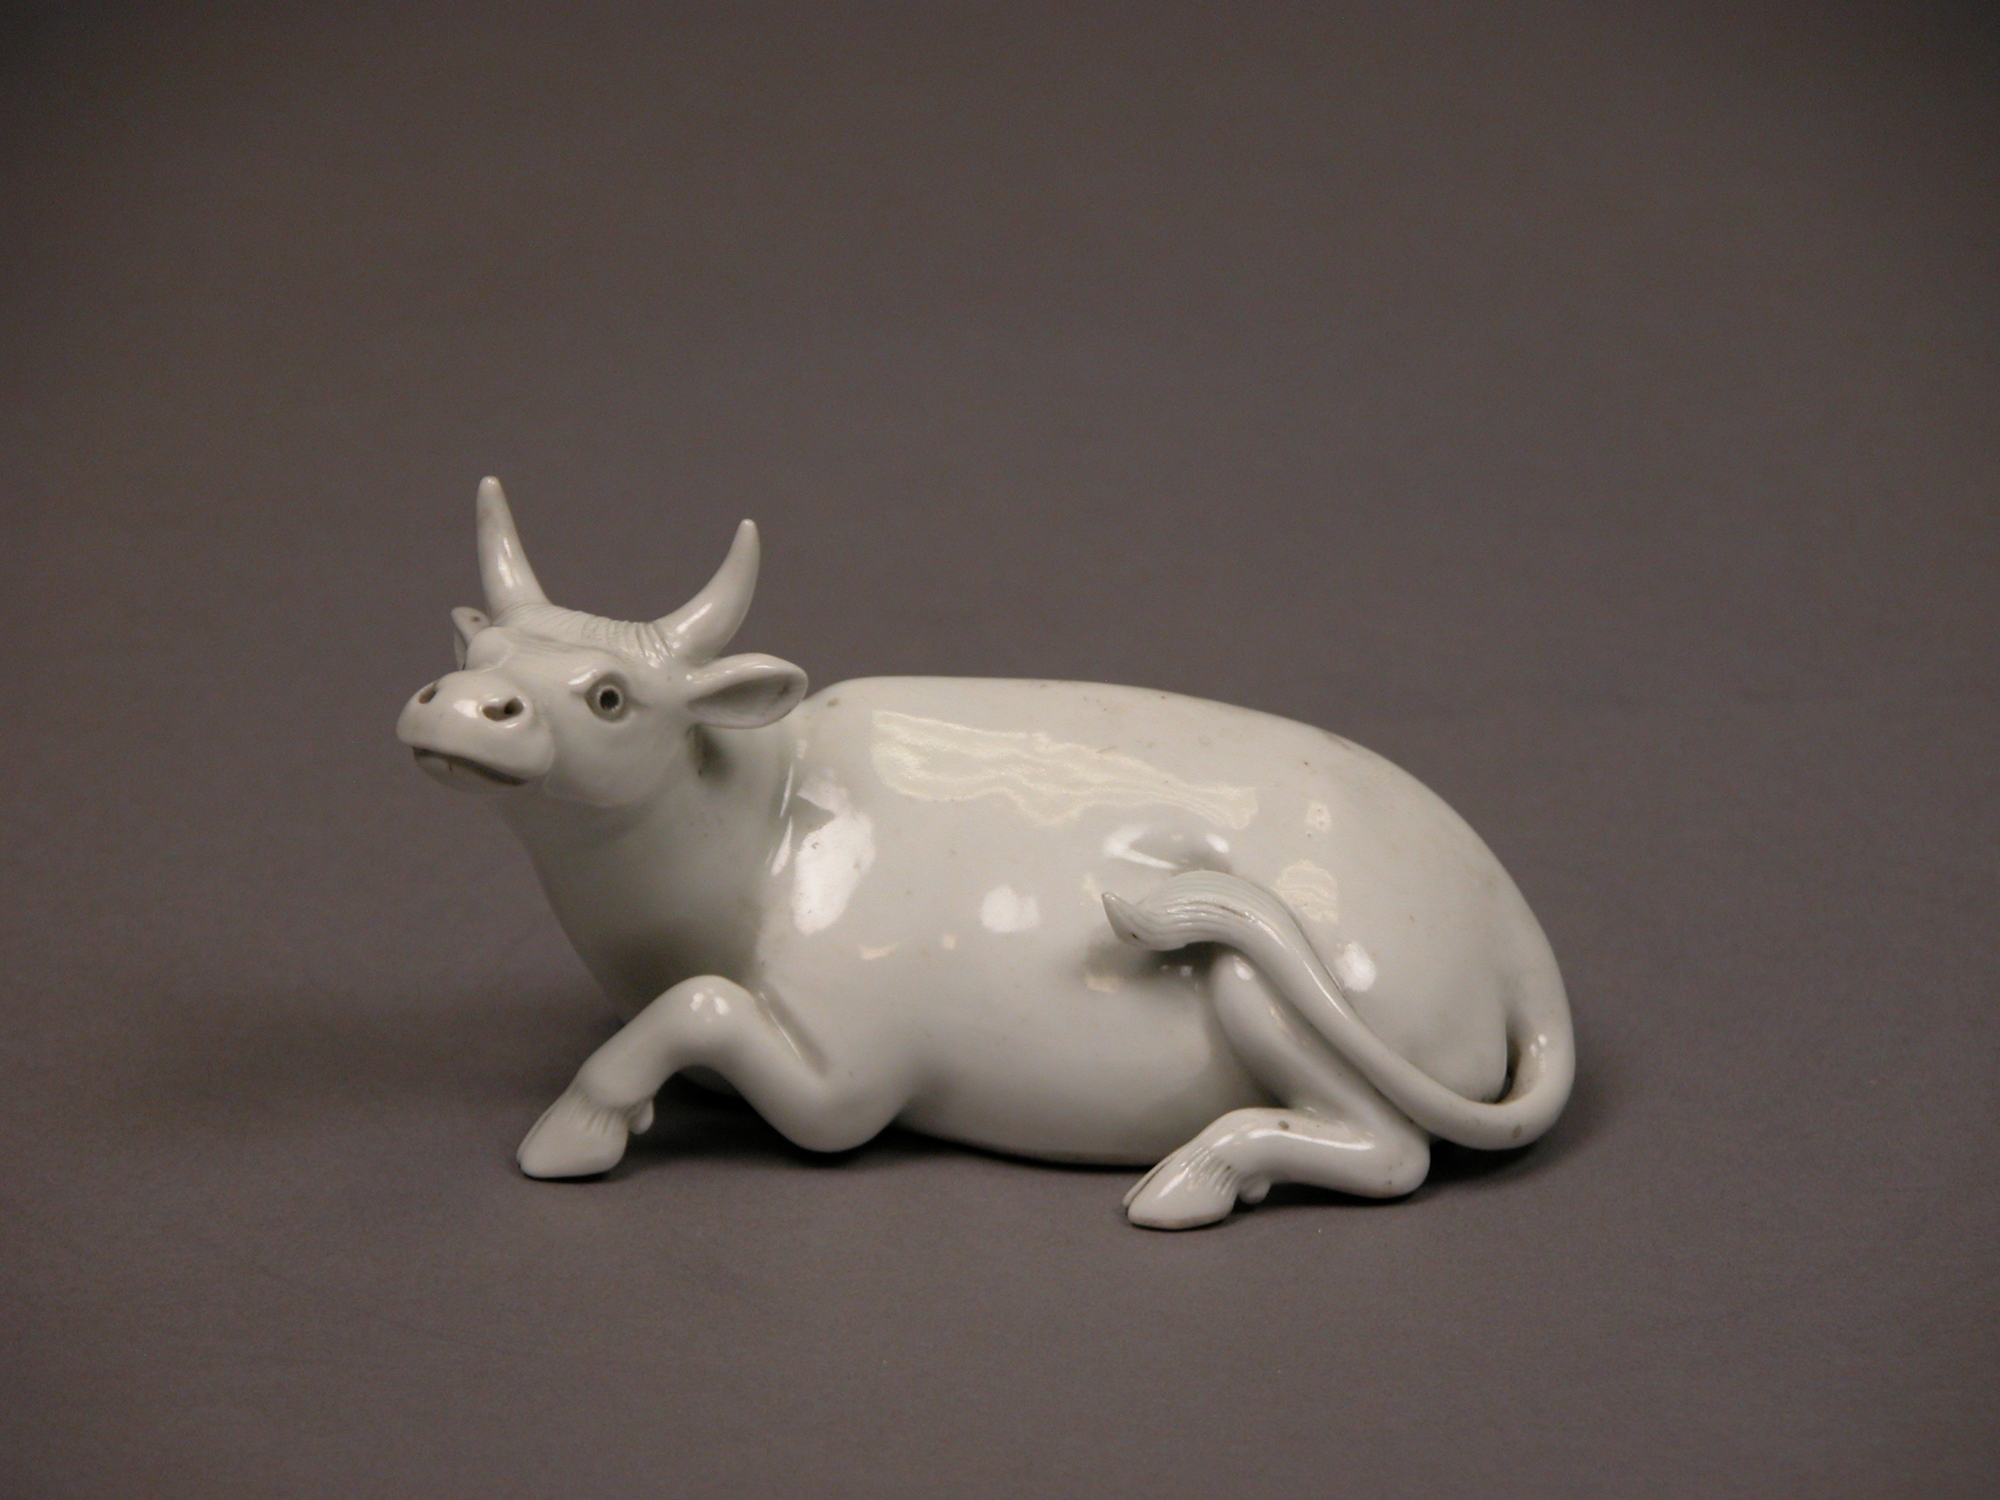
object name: figure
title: Cow Reclining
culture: japanese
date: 1820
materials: porcelain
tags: cows